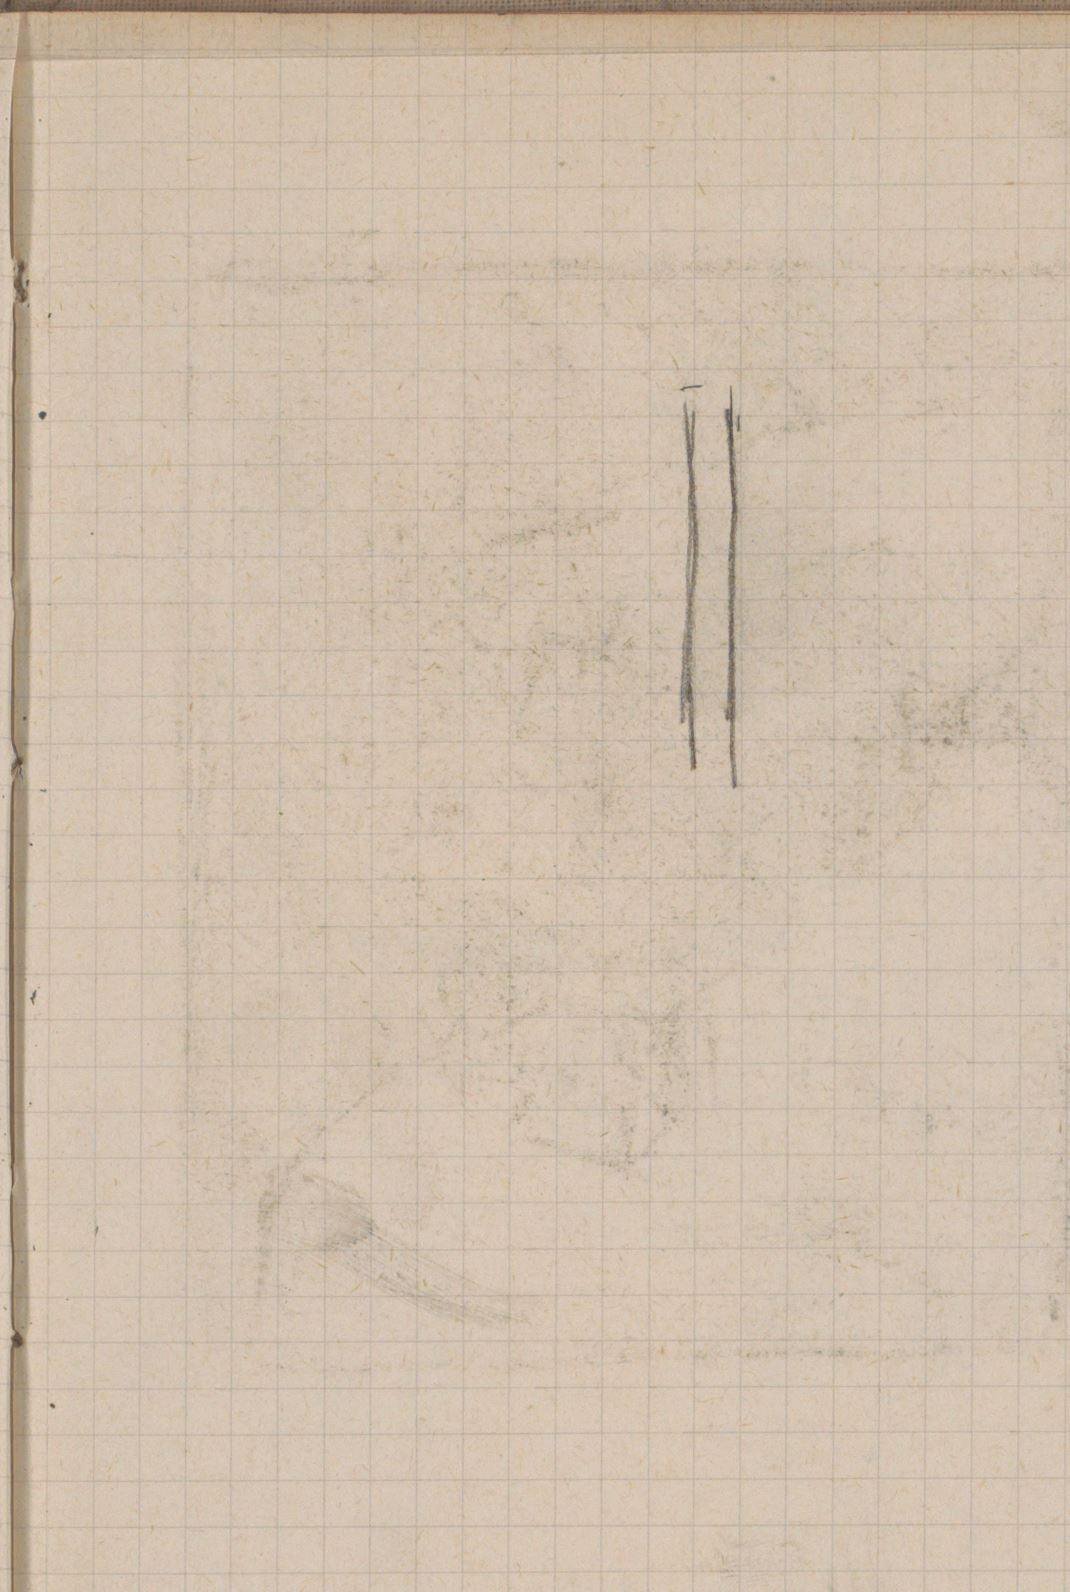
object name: sketchbook leaf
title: Studieblad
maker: marius bauer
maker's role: draughtsman, print maker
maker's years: 1867-1932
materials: chalk, paper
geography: istanbul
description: Pagina 50 uit een schetsboek met 51 bladen.